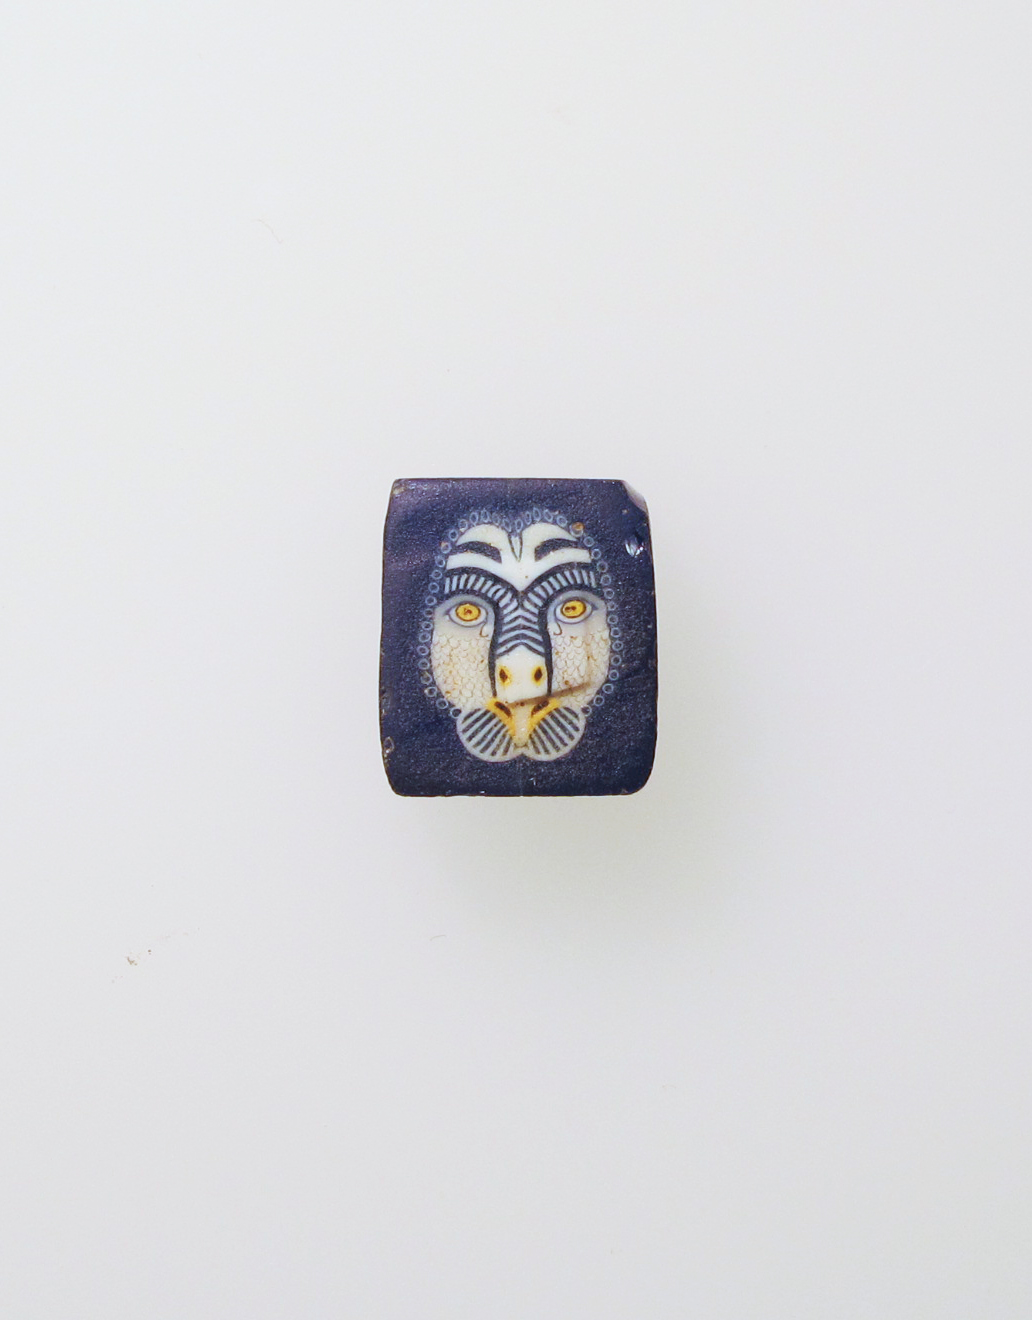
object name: mosaic plaque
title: Mosaic glass inlay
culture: roman, egyptian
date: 100 BCE-100 CE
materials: glass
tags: masks